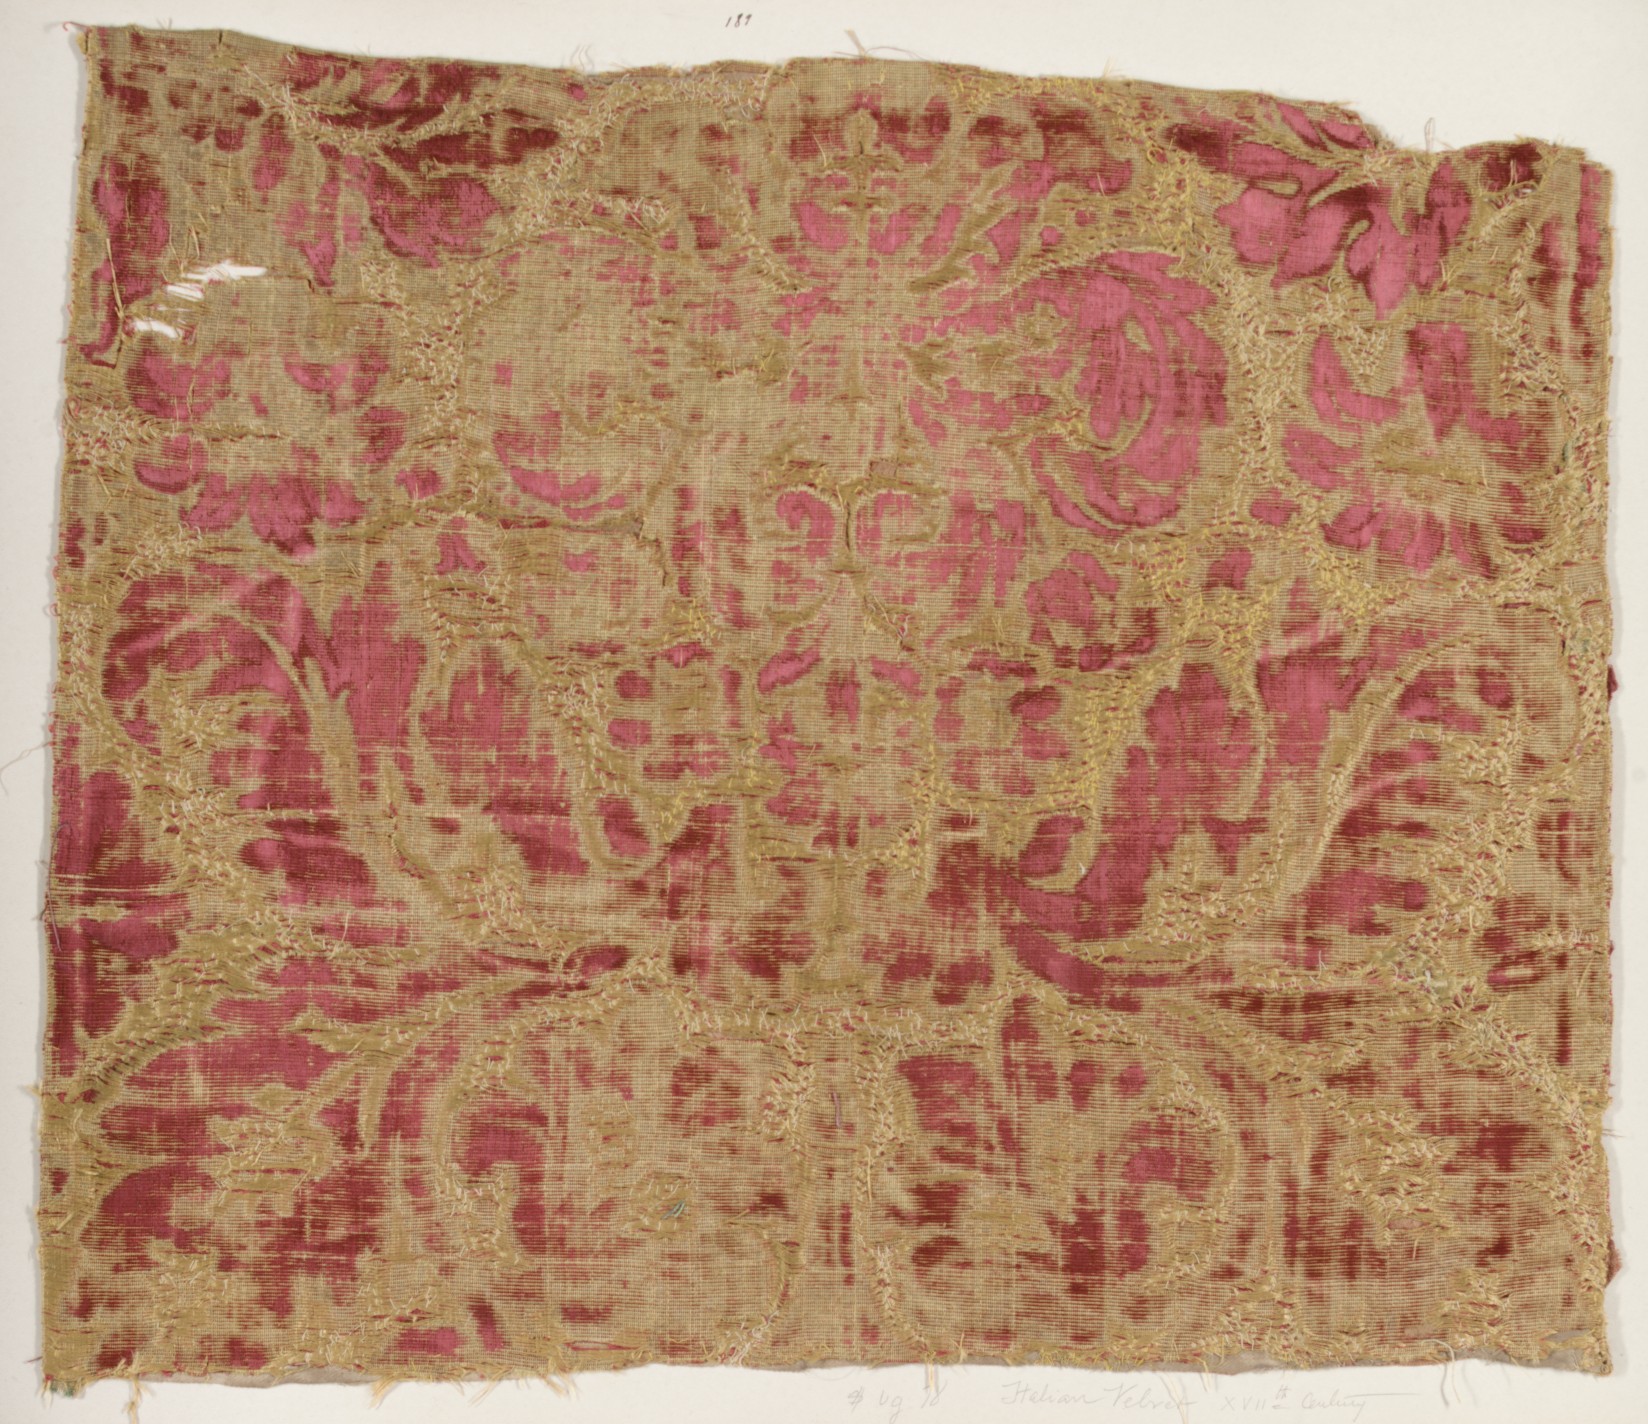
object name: fragment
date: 1601-1700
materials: silk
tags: leaves